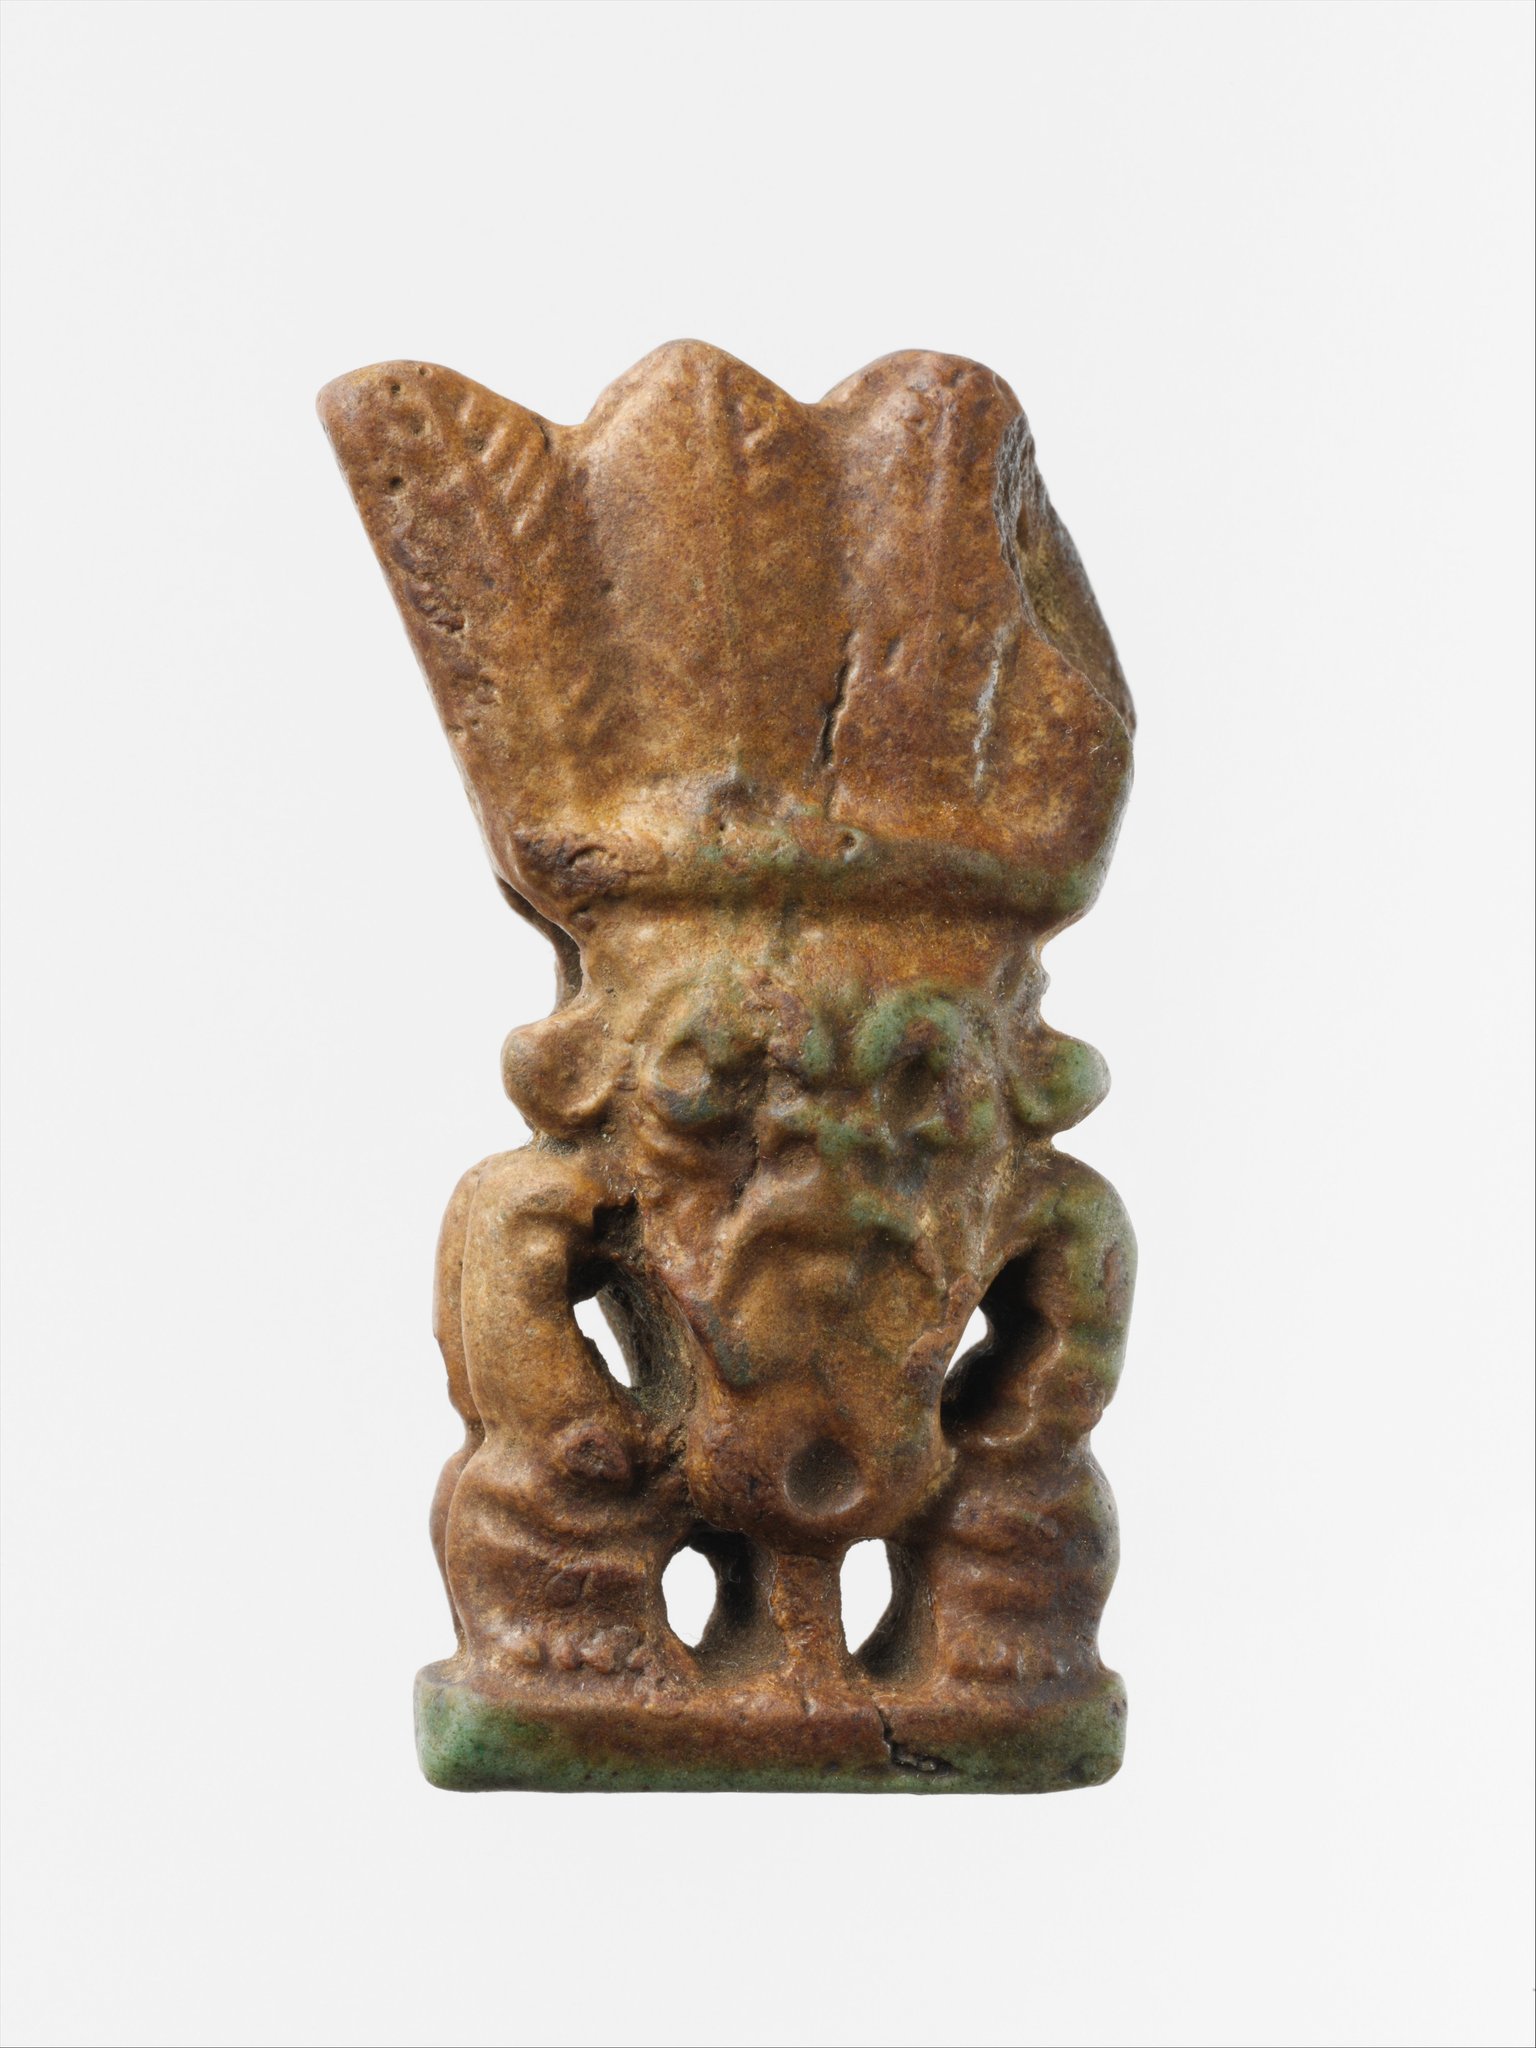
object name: amulet, be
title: Faience amulet of Bes image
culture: egyptian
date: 1090-900 BCE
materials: faience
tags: bes